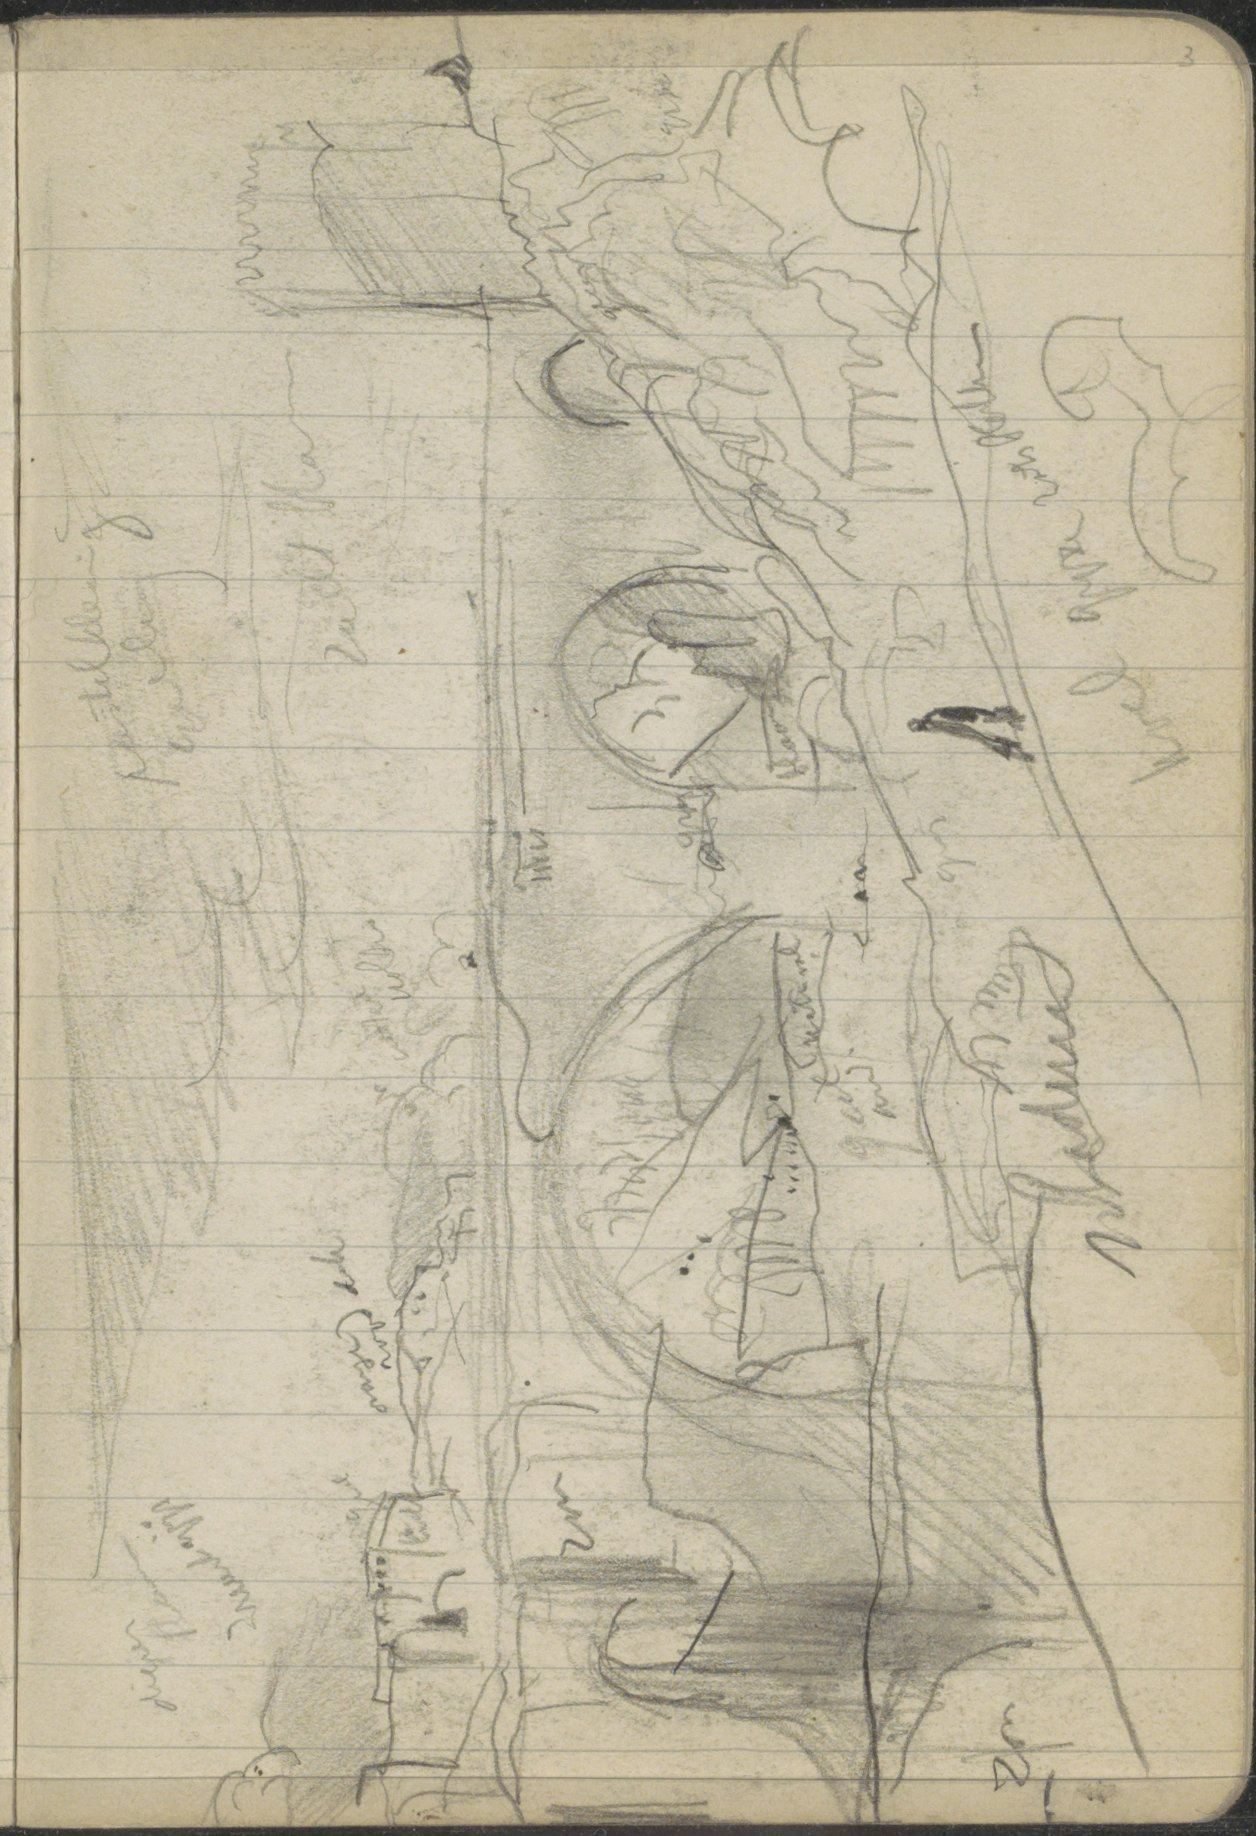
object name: sketchbook leaf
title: Gezicht op de Alcantára brug over de Taag in Toledo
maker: marius bauer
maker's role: draughtsman, print maker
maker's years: 1867-1932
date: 1902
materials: pencil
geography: toledo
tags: city-view, and landscape with man-made constructions, river, bridge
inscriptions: kleurnotitie, handgeschreven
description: Pagina 3 uit een schetsboek met 50 bladen.